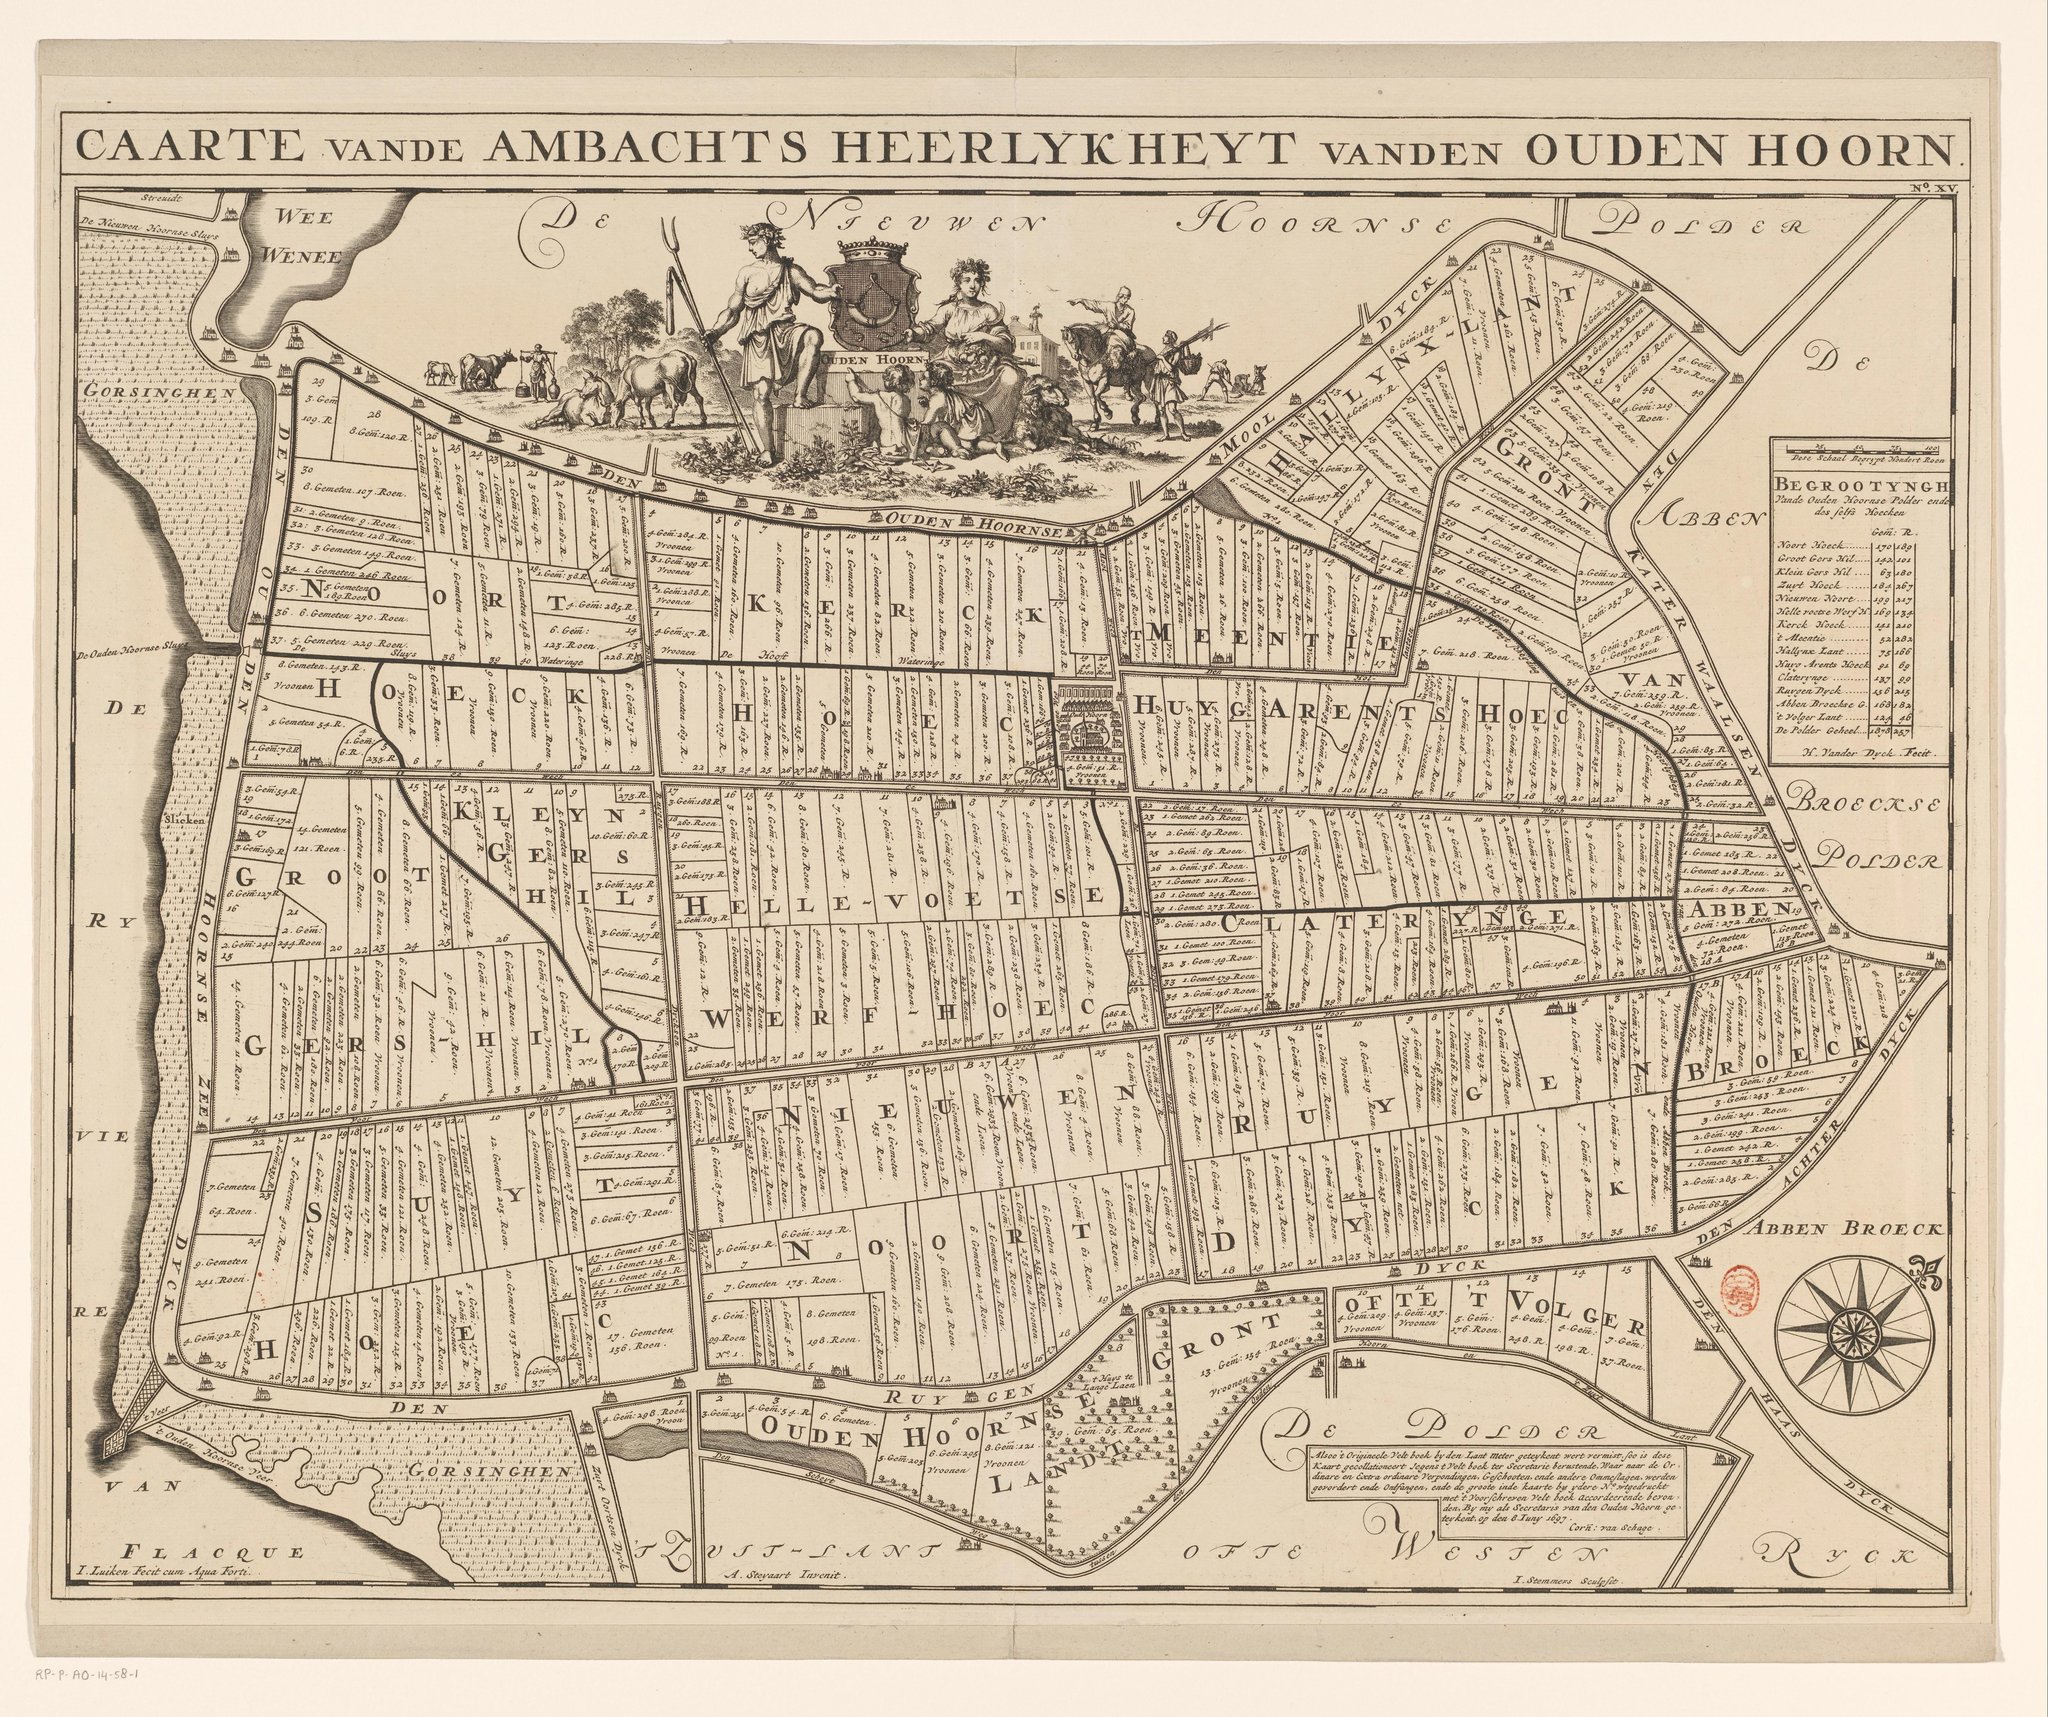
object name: print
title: Voorne Caart-boeck / Caartboeck van Voorne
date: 1701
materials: paper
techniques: engraving, etching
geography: amsterdam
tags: coat of arms (as symbol of the state, etc.), (story of) ceres (demeter), agricultural implements: pitchfork, maps of separate countries or regions, farmers, agricultural implements: flail, carrying something with yoke, polder, reclaimed land, milkmaid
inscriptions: collector's mark: Lugt 195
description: Deze kaart is onderdeel van het zogenaamde 'Voorne Caart-boeck' / 'Caartboeck van Voorne', dat bestaat uit een titelpagina (zie RP-P-1942-347), drie algemene kaarten (van Oost-, West- en Zuid-Voorne)* en dertig detailkaarten. Het kaartboek werd vervaardigd in opdracht van de Staten van Voorne en werd in 1701 uitgegeven. Een deel van de koperplaten is bewaard gebleven en in de negentiende en twintigste eeuw gebruikt voor herdrukken. *Over de naam Voorne kan verwarring ontstaan omdat de betekenis door de eeuwen heen is veranderd. Vroeger stonden de (voormalige) eilanden Voorne, Goeree en Overflakkee – allen historisch gezien onderdeel van het Land van Voorne – bekend als respectievelijk Oost-, West- en Zuid-Voorne.